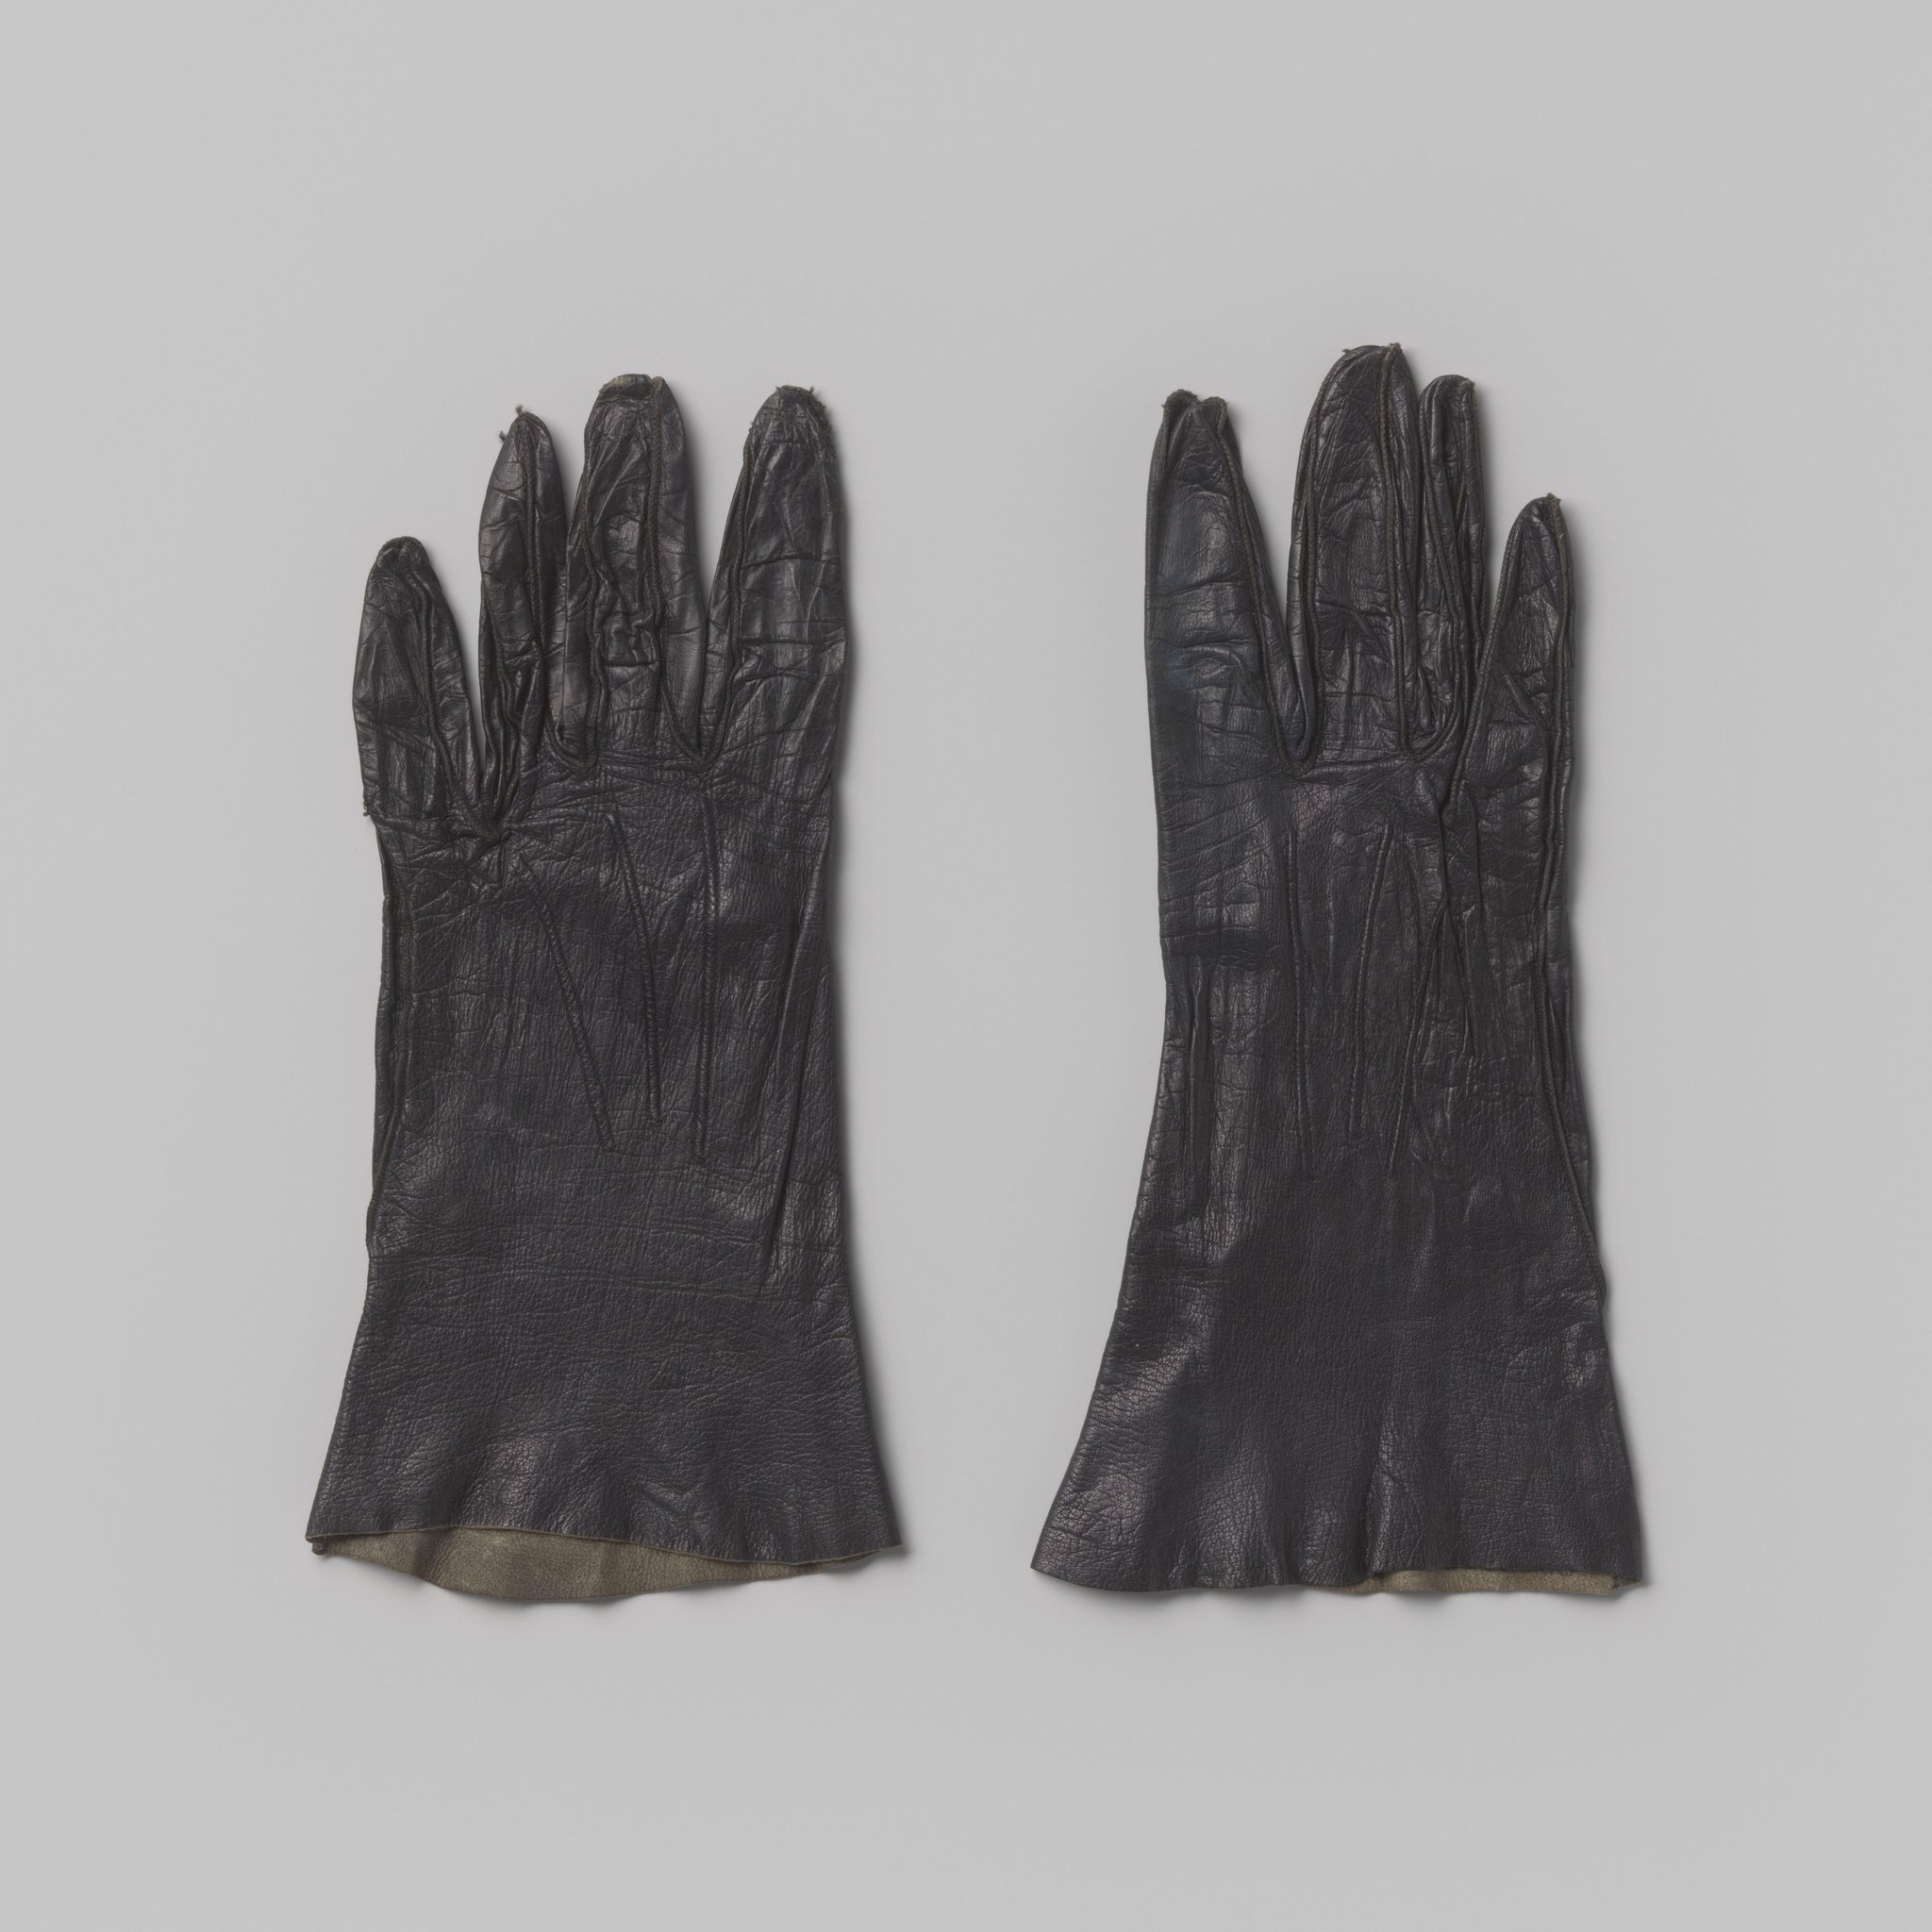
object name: glove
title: Dameshandschoen van zwart glacéleer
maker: Anonymous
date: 1950-1960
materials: glazing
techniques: glazing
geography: amsterdam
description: Rechter dameshandschoen van zwart glacéleer. Model: kort, met drie peesnaadjes op de handrug.